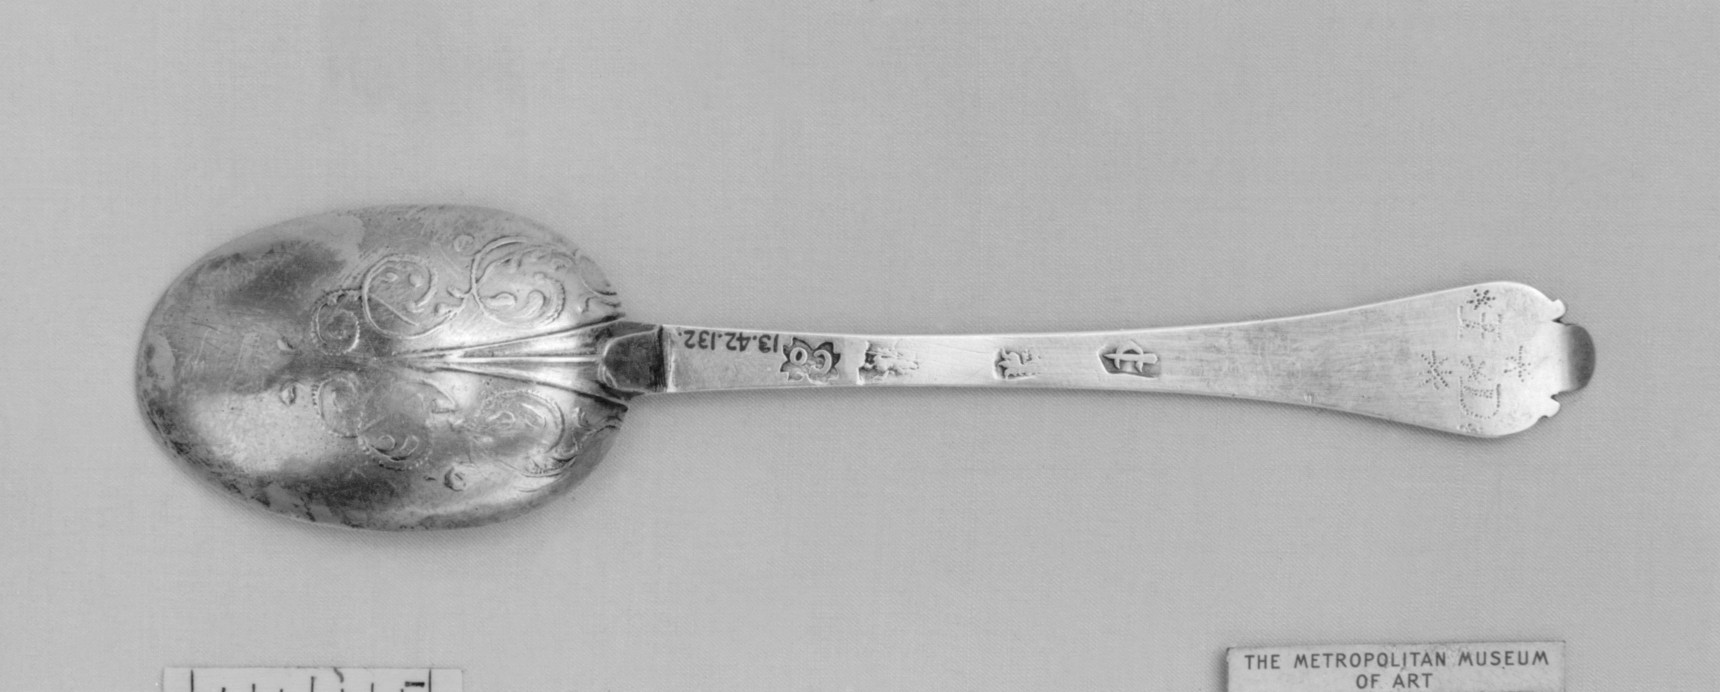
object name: spoon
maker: lawrence coles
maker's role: maker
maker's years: 1669-1714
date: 1698-1699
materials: silver